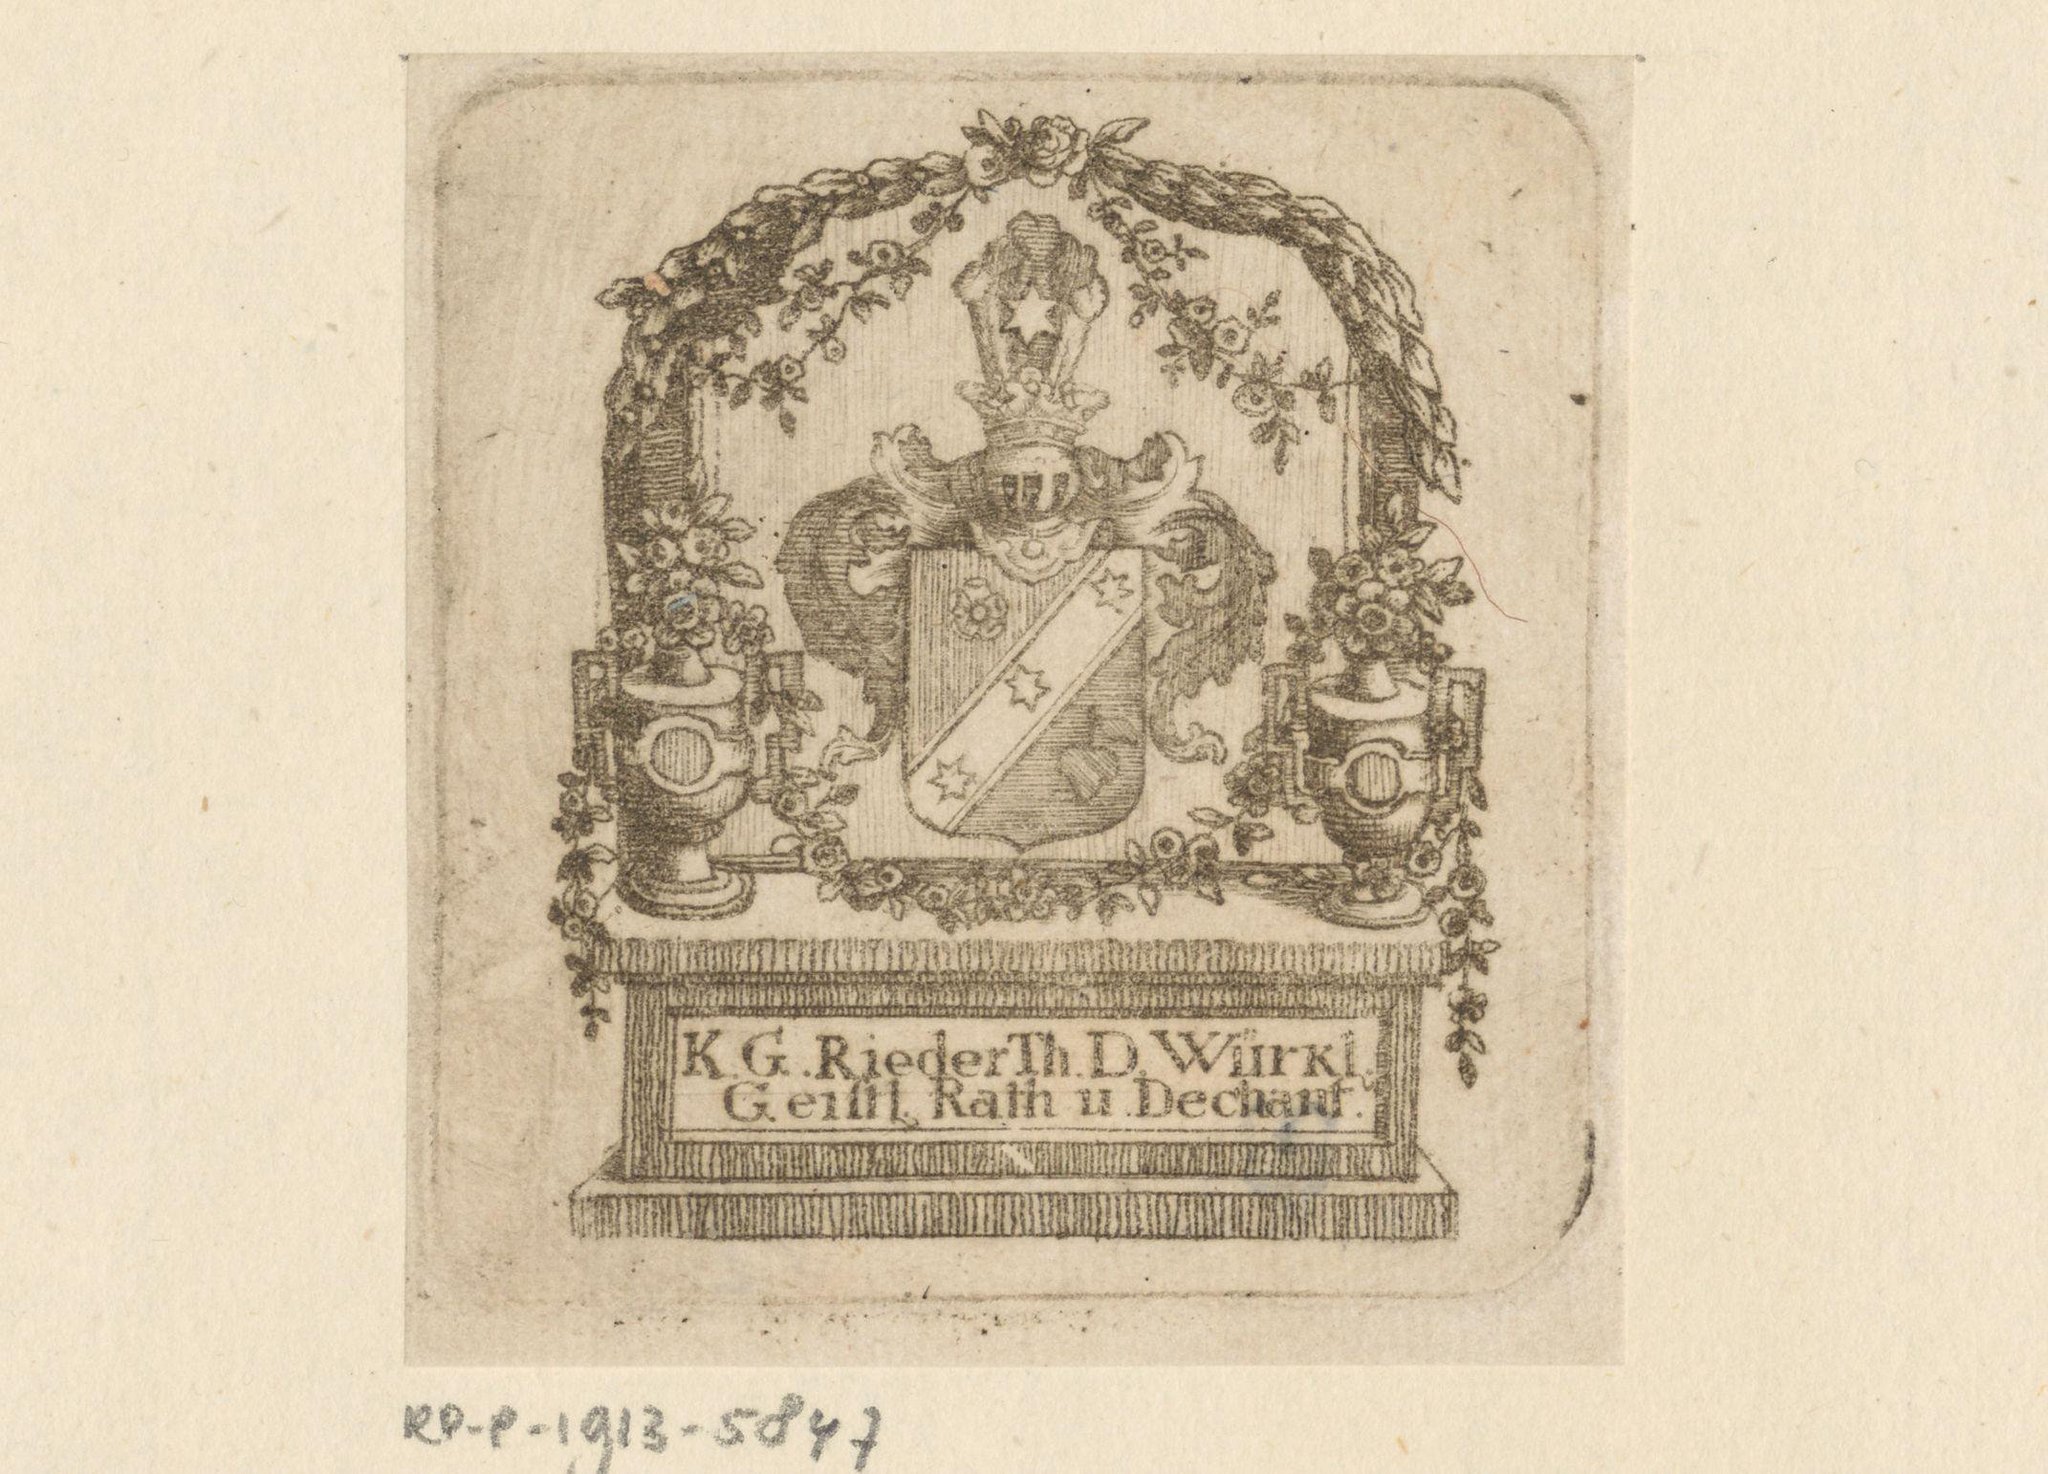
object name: bookplate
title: Ex libris van K.G. Rieder en Th.D. Würkl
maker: Anonymous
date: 1750-1850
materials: paper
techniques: etching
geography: germany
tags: stars, ornament ~ festoon, garland, armorial bearing, heraldry, garden vase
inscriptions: collector's mark: Lugt 2233, collector's mark: Lugt 2760